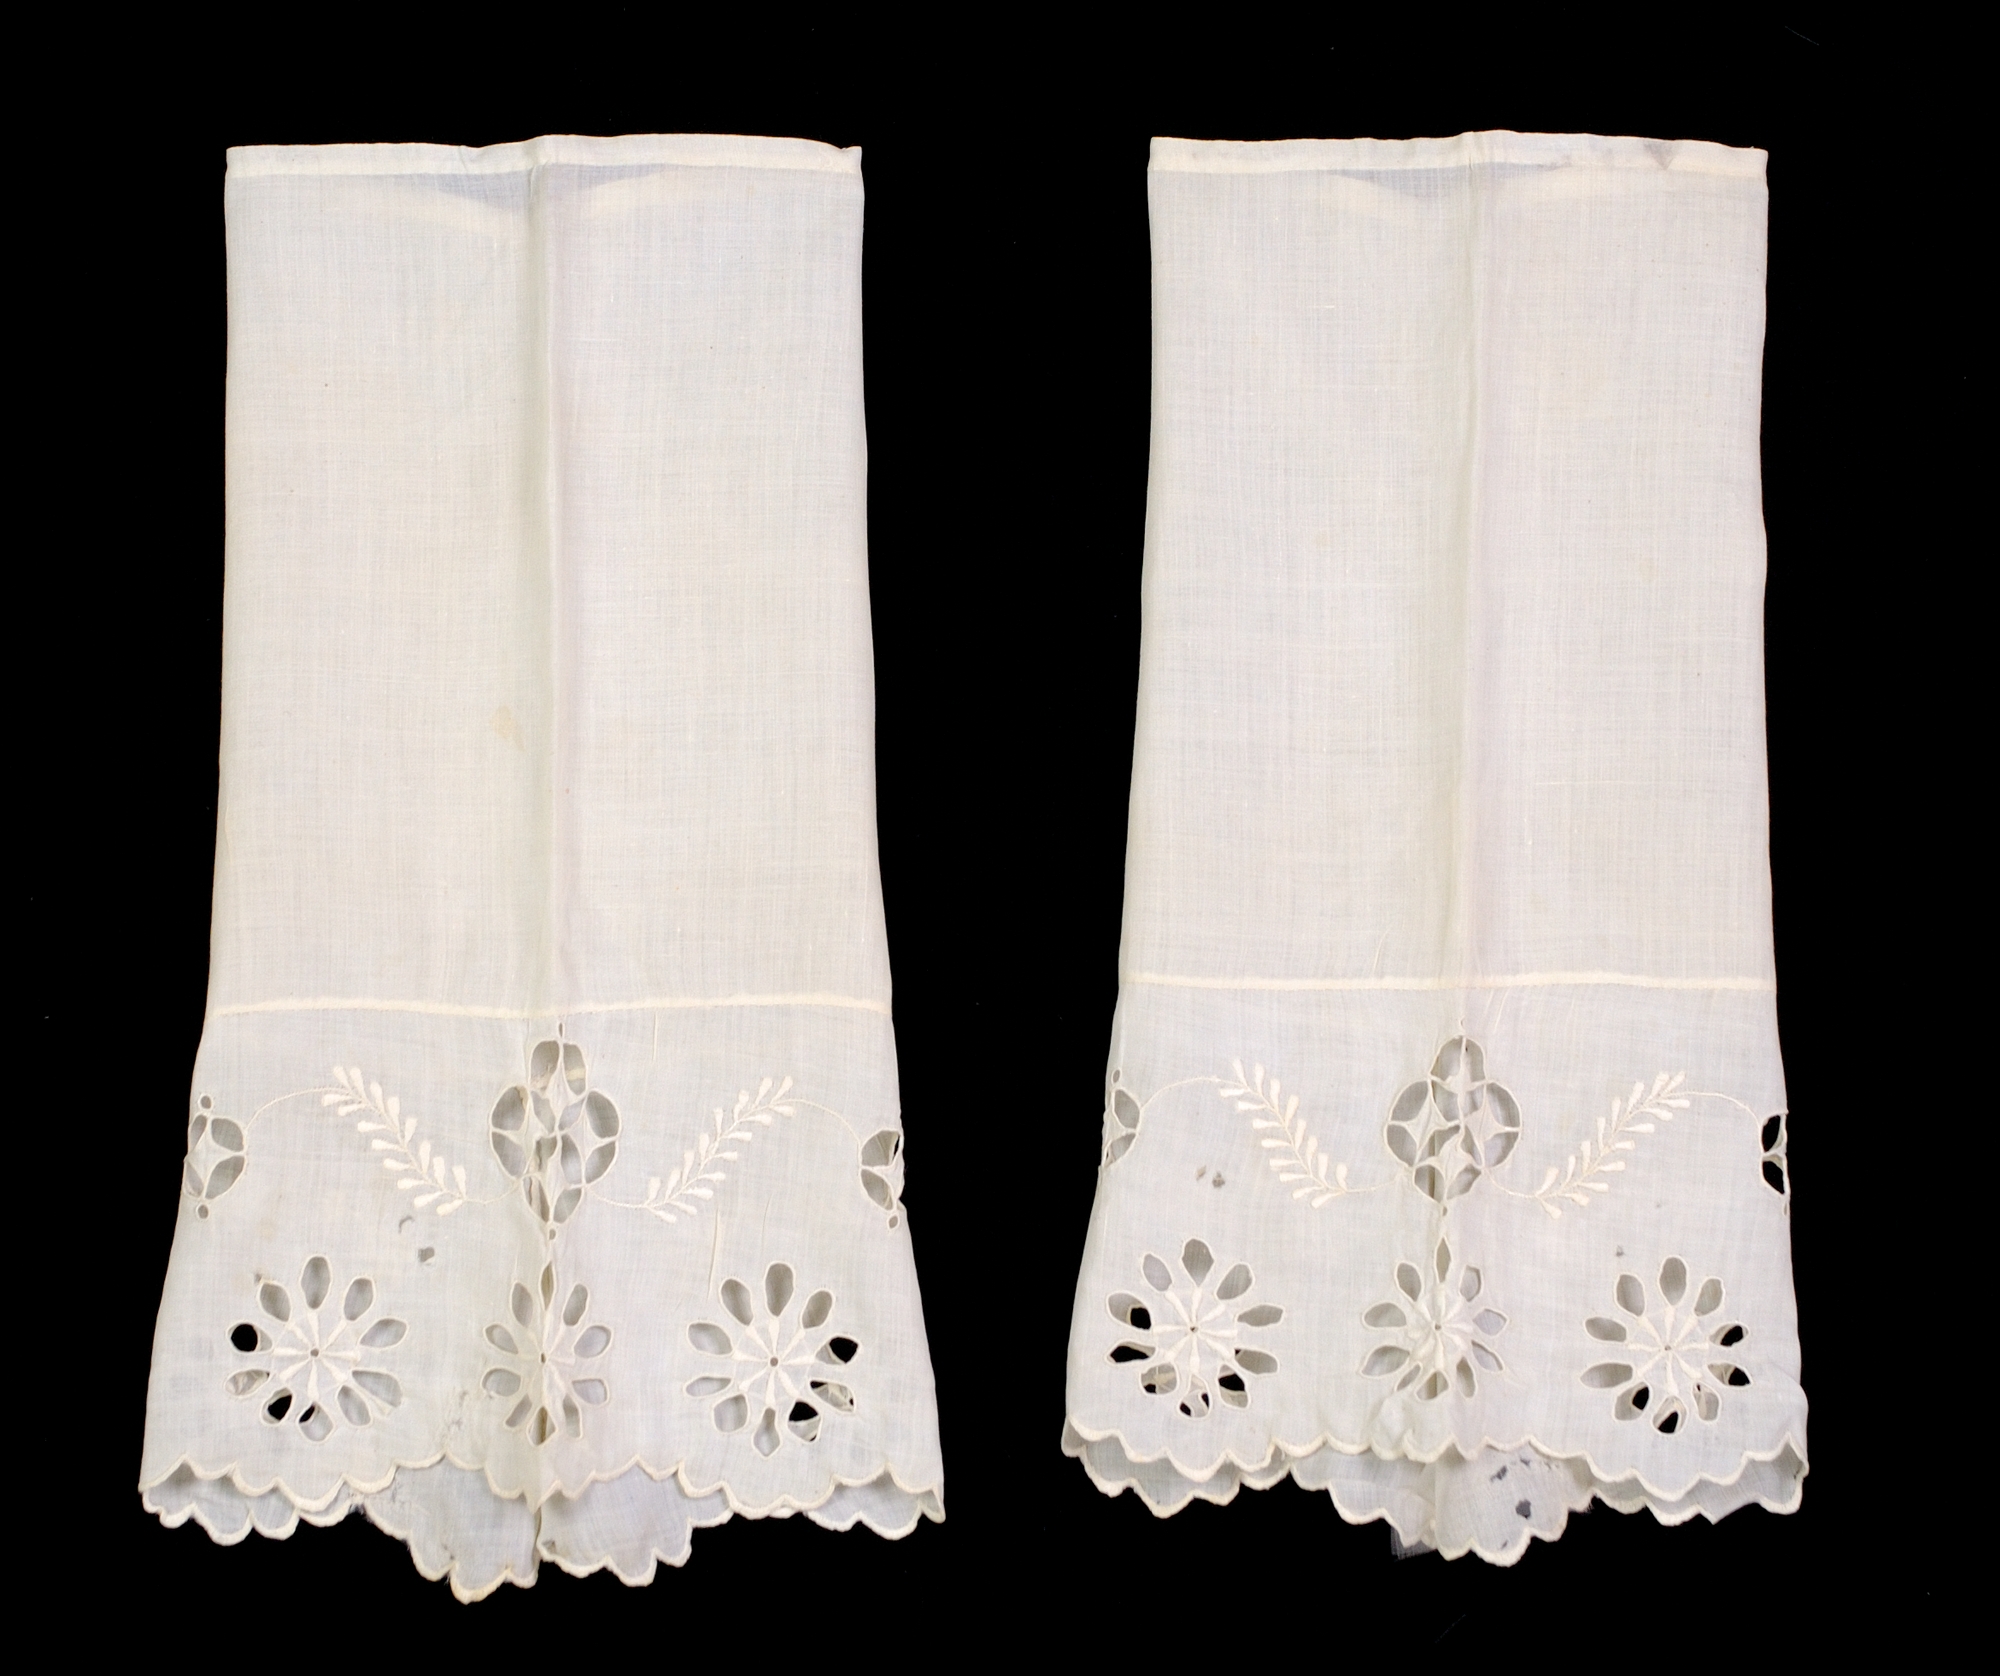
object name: undersleeves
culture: american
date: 1855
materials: cotton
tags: flowers